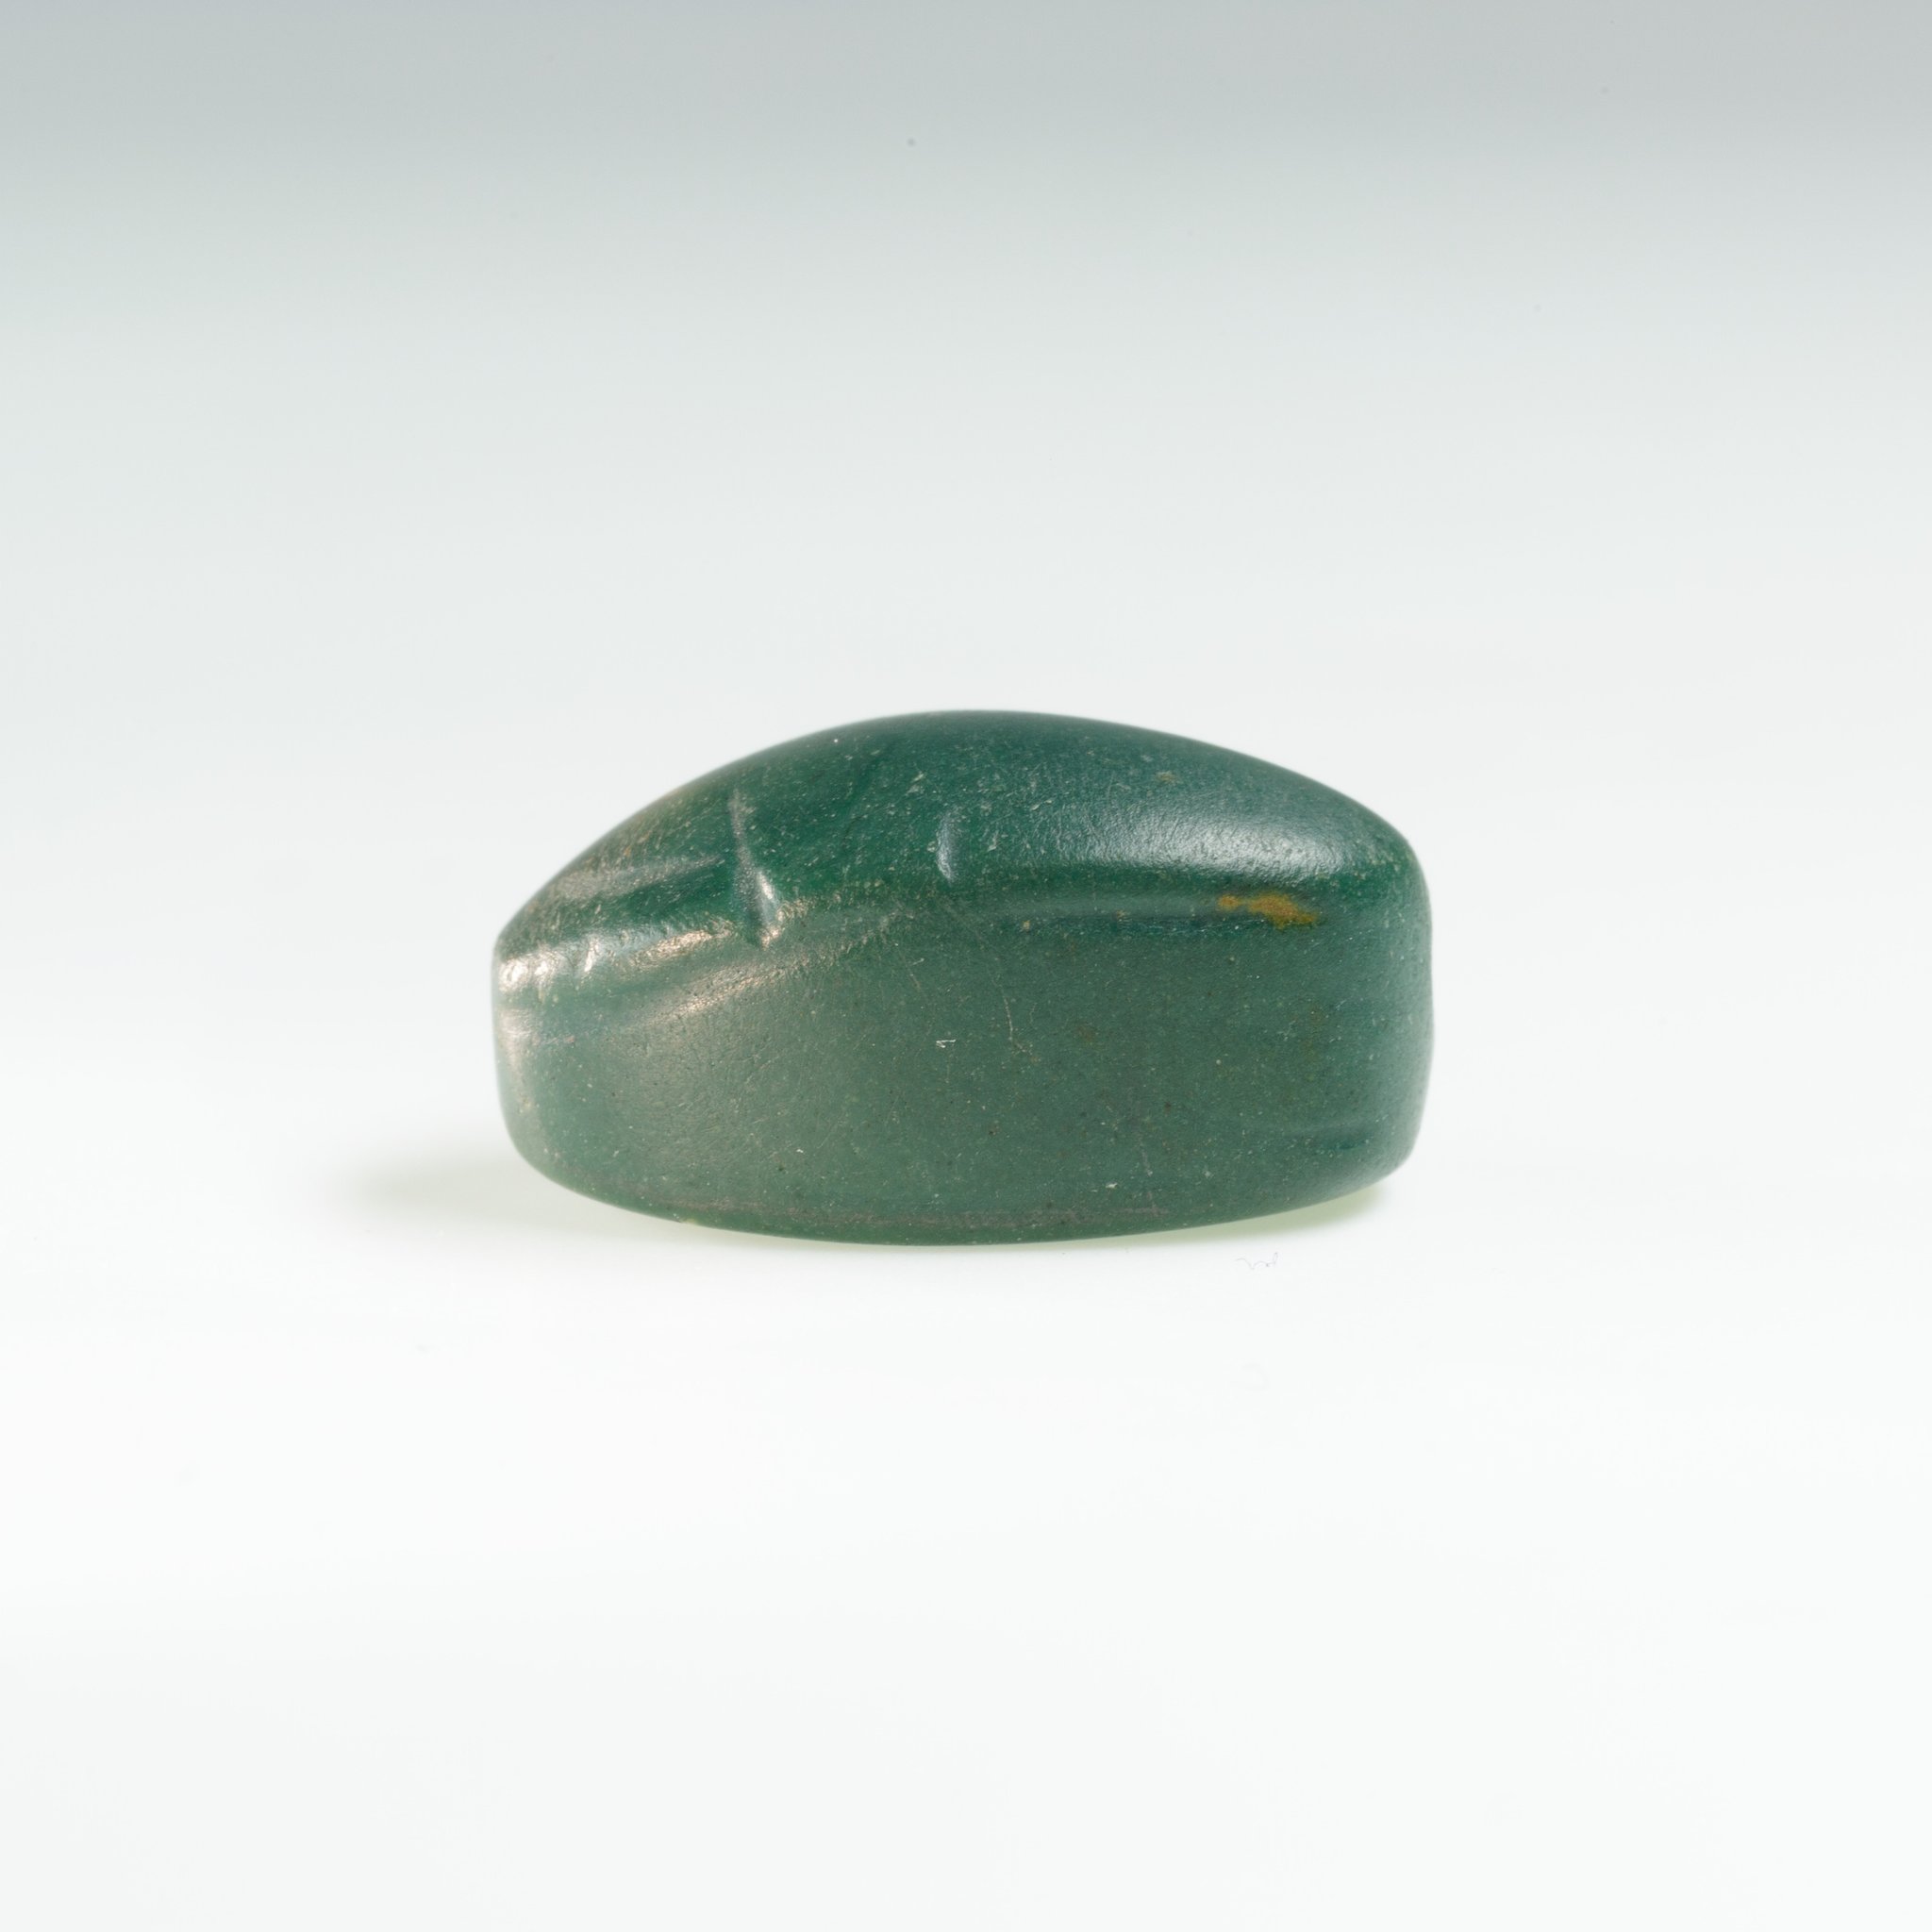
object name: ring with scarab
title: Scarab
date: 2030-1550 BCE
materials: jasper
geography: egypt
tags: scarabs